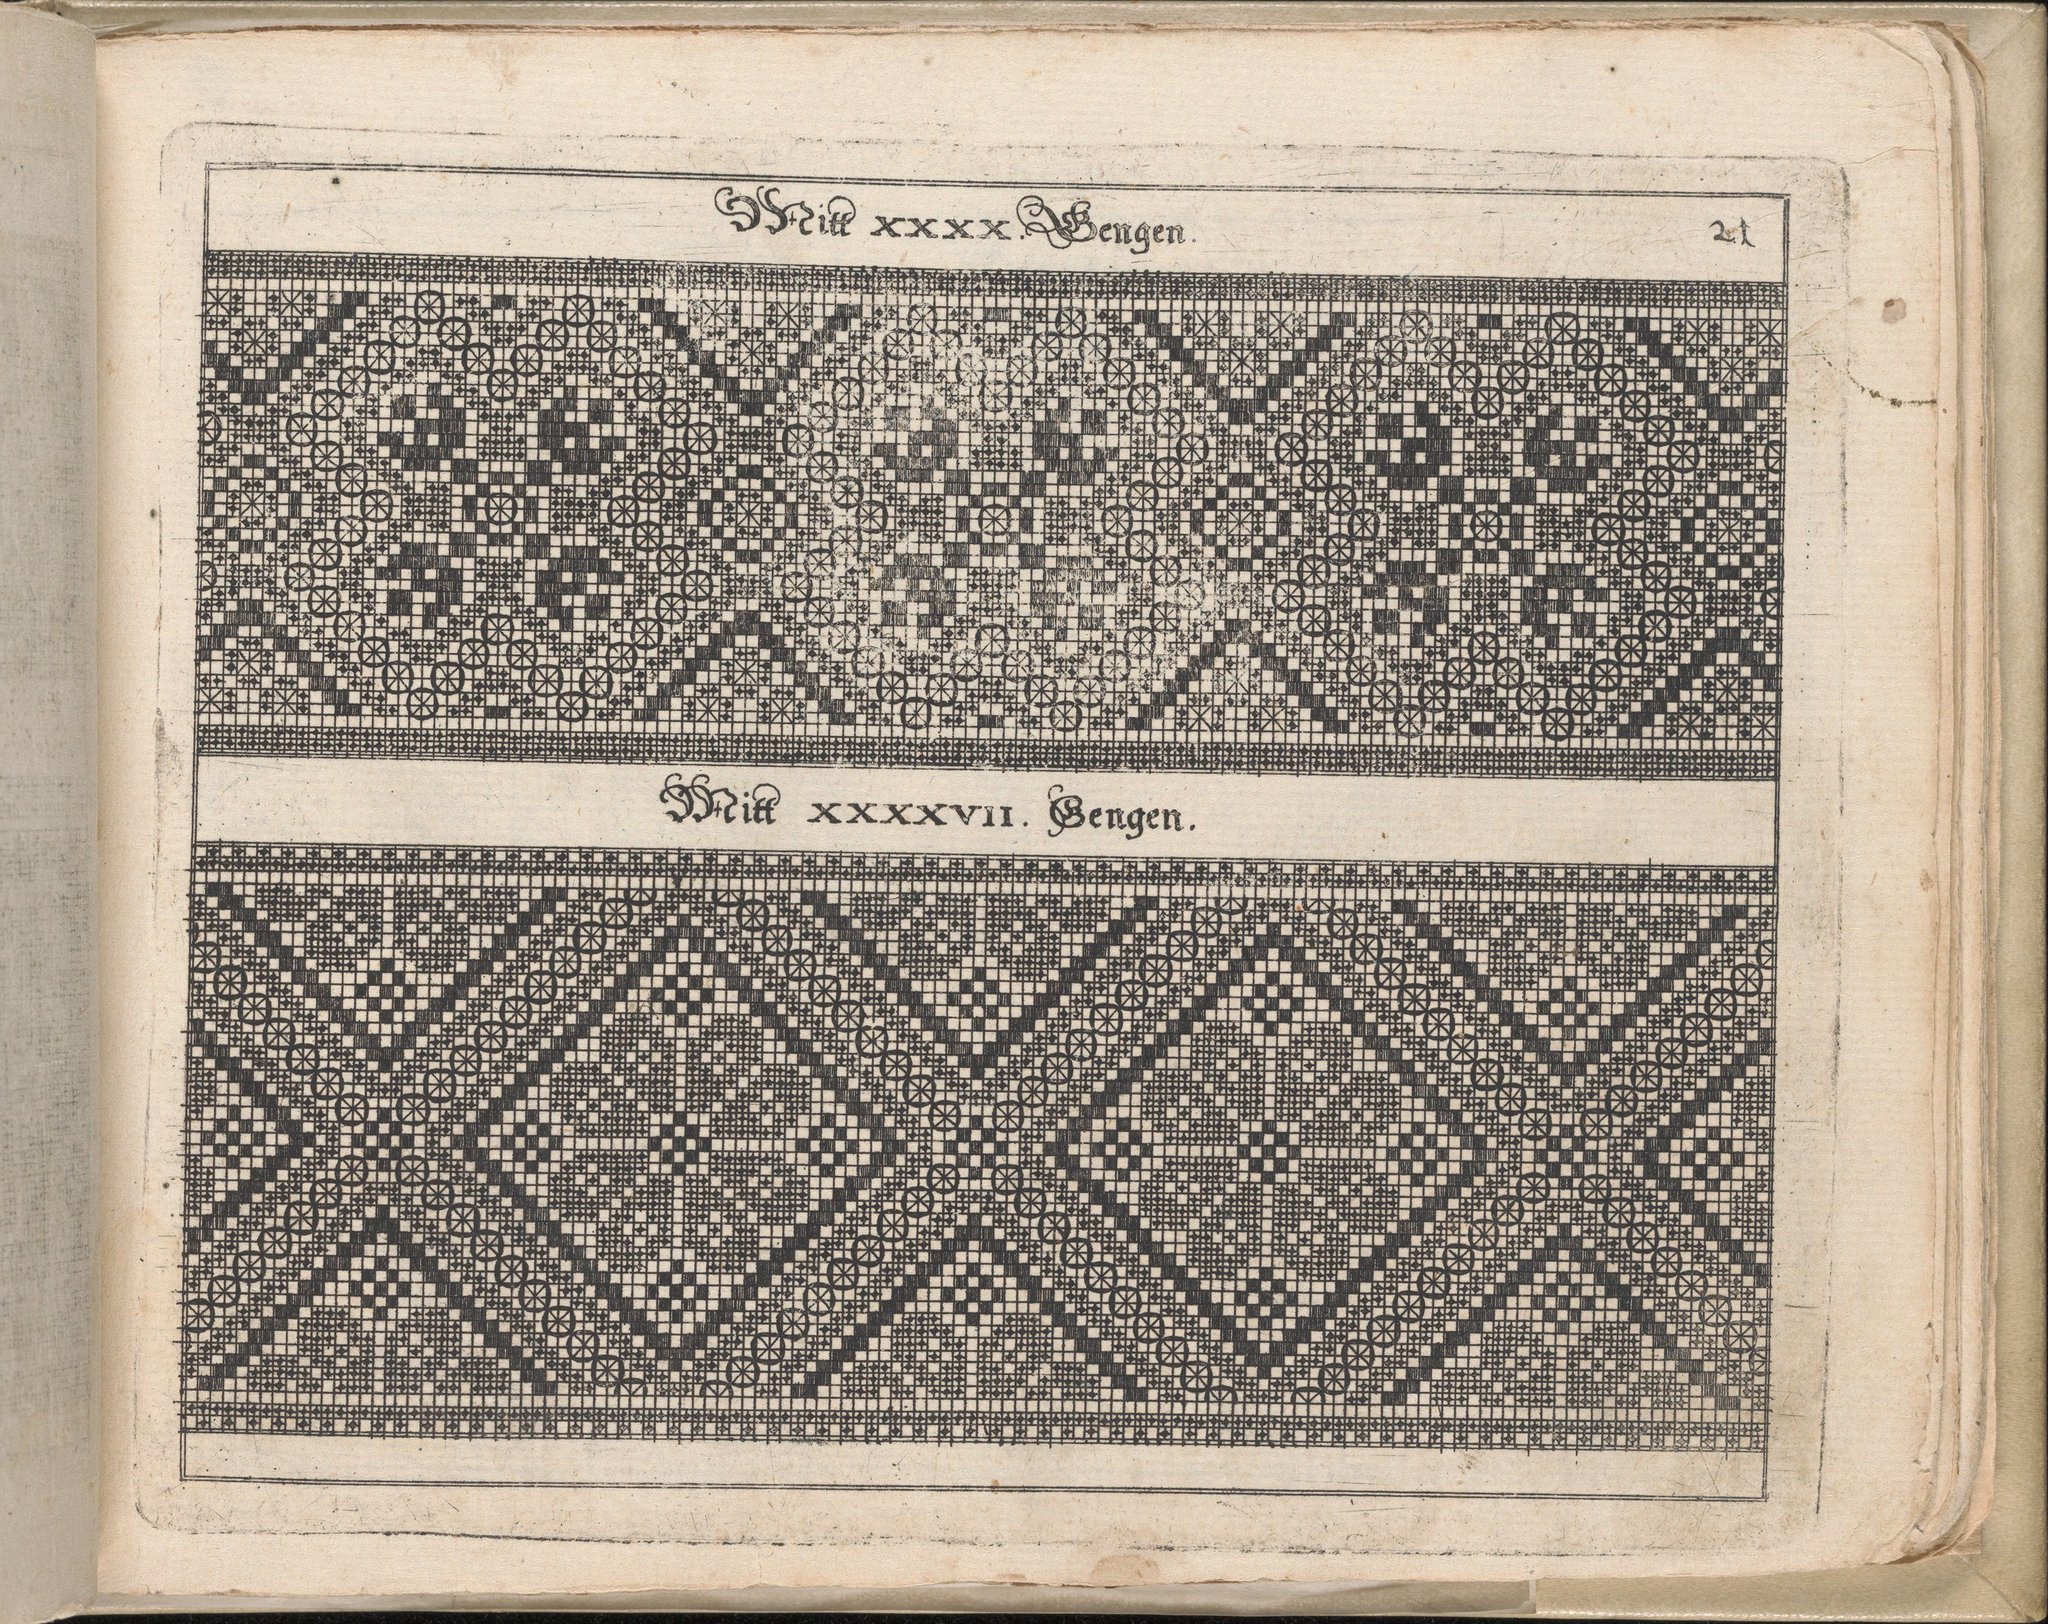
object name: book print ornament architecture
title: Schön Neues Modelbuch (Page 26 recto)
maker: johann sibmacher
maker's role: designer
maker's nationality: german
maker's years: 1590-1611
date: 1597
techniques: etching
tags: ornament